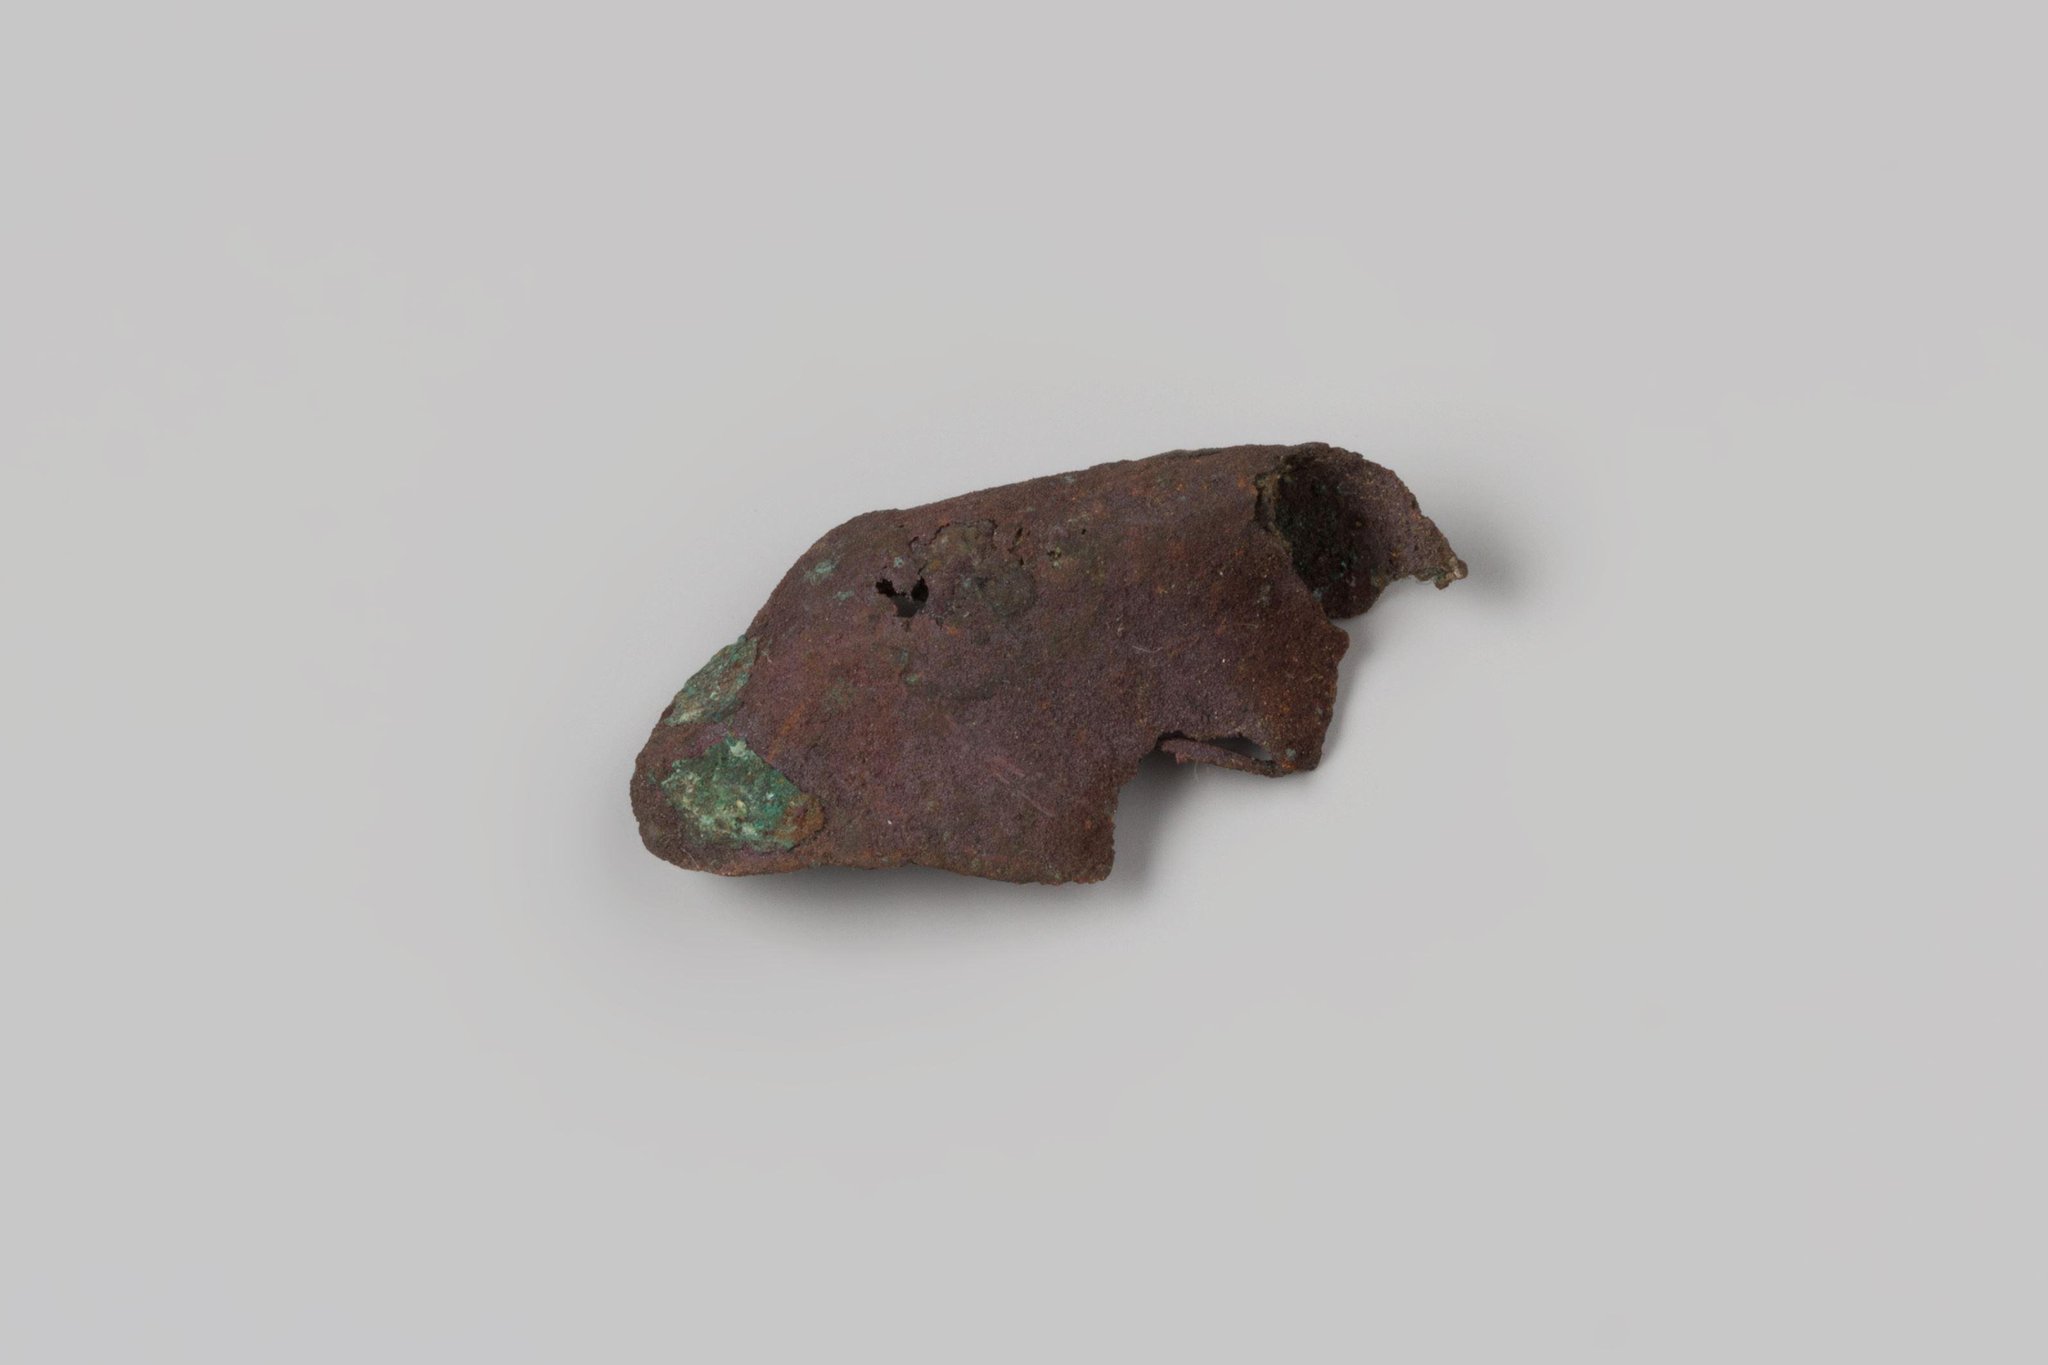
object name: scheepswrakvondst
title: Fragment van koper uit het wrak van de Oost-Indiëvaarder Hollandia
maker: Anonymous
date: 1700-1743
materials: copper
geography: netherlands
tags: verenigde oostindische compagnie, hollandia (schip), annet